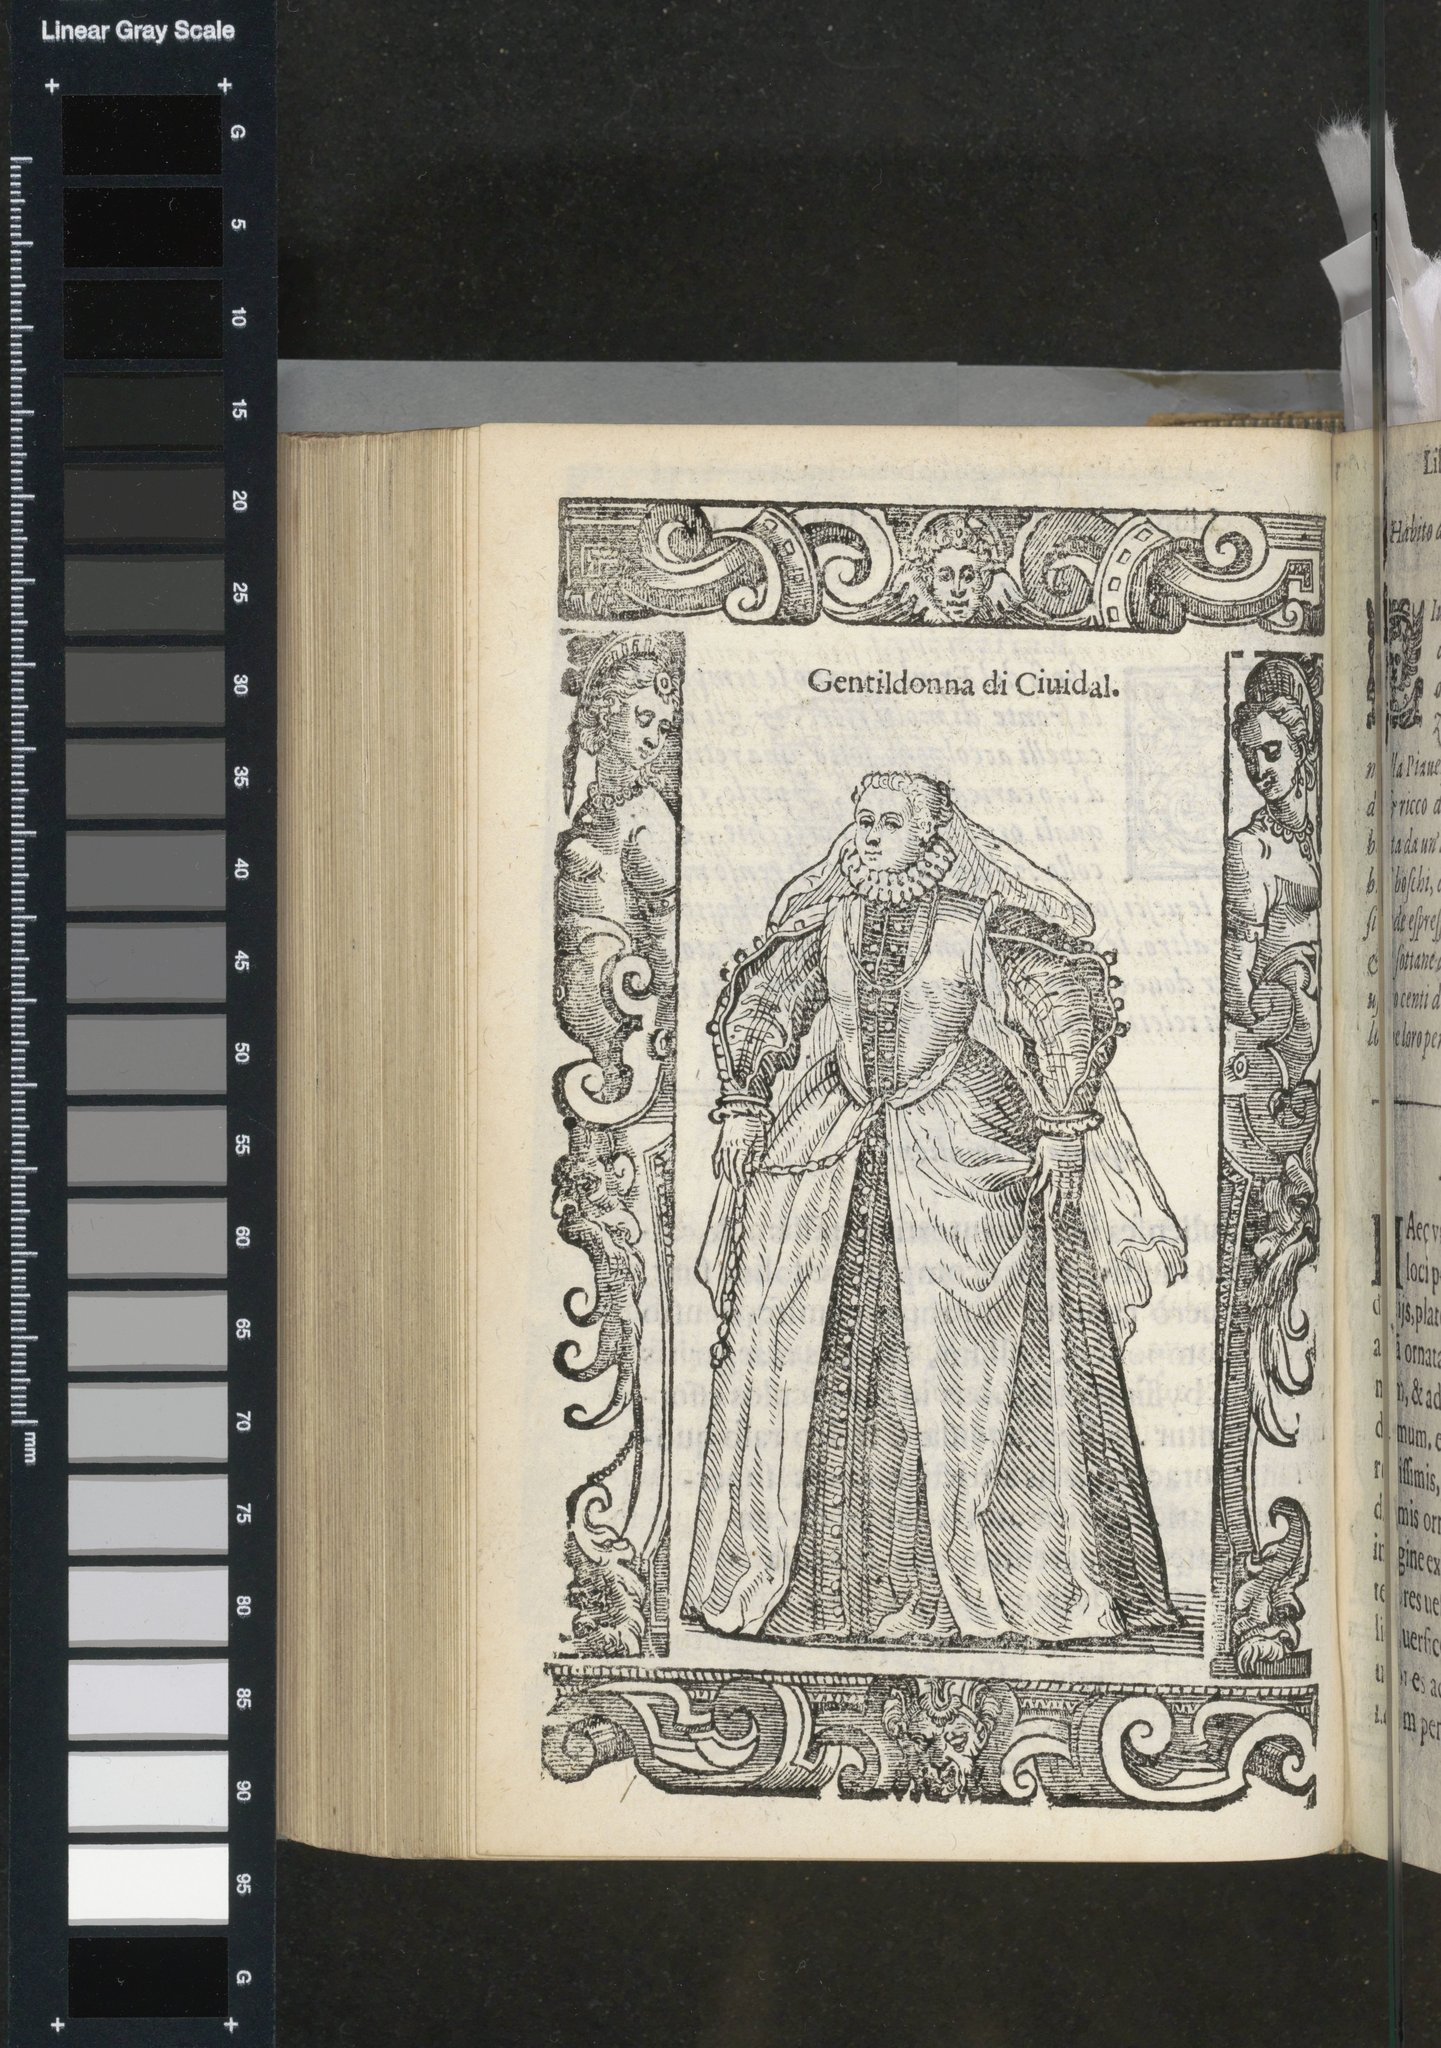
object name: costume print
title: Habiti antichi, et moderni di tutto il mondo...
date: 1598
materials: paper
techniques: woodcut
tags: fashion plates